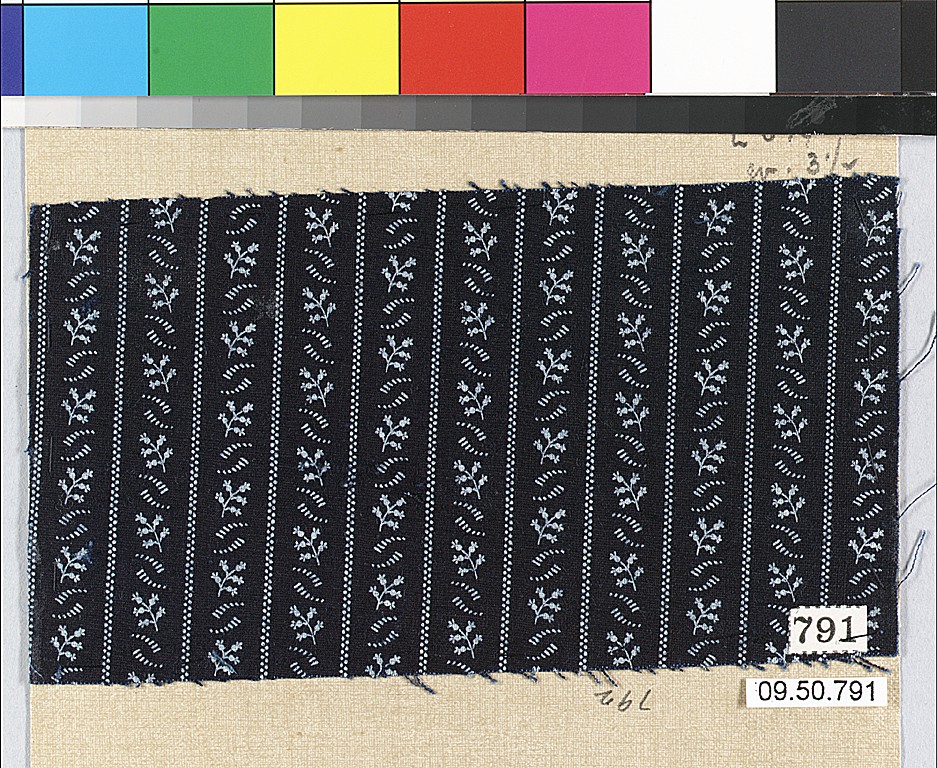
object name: piece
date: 1801-1900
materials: cotton